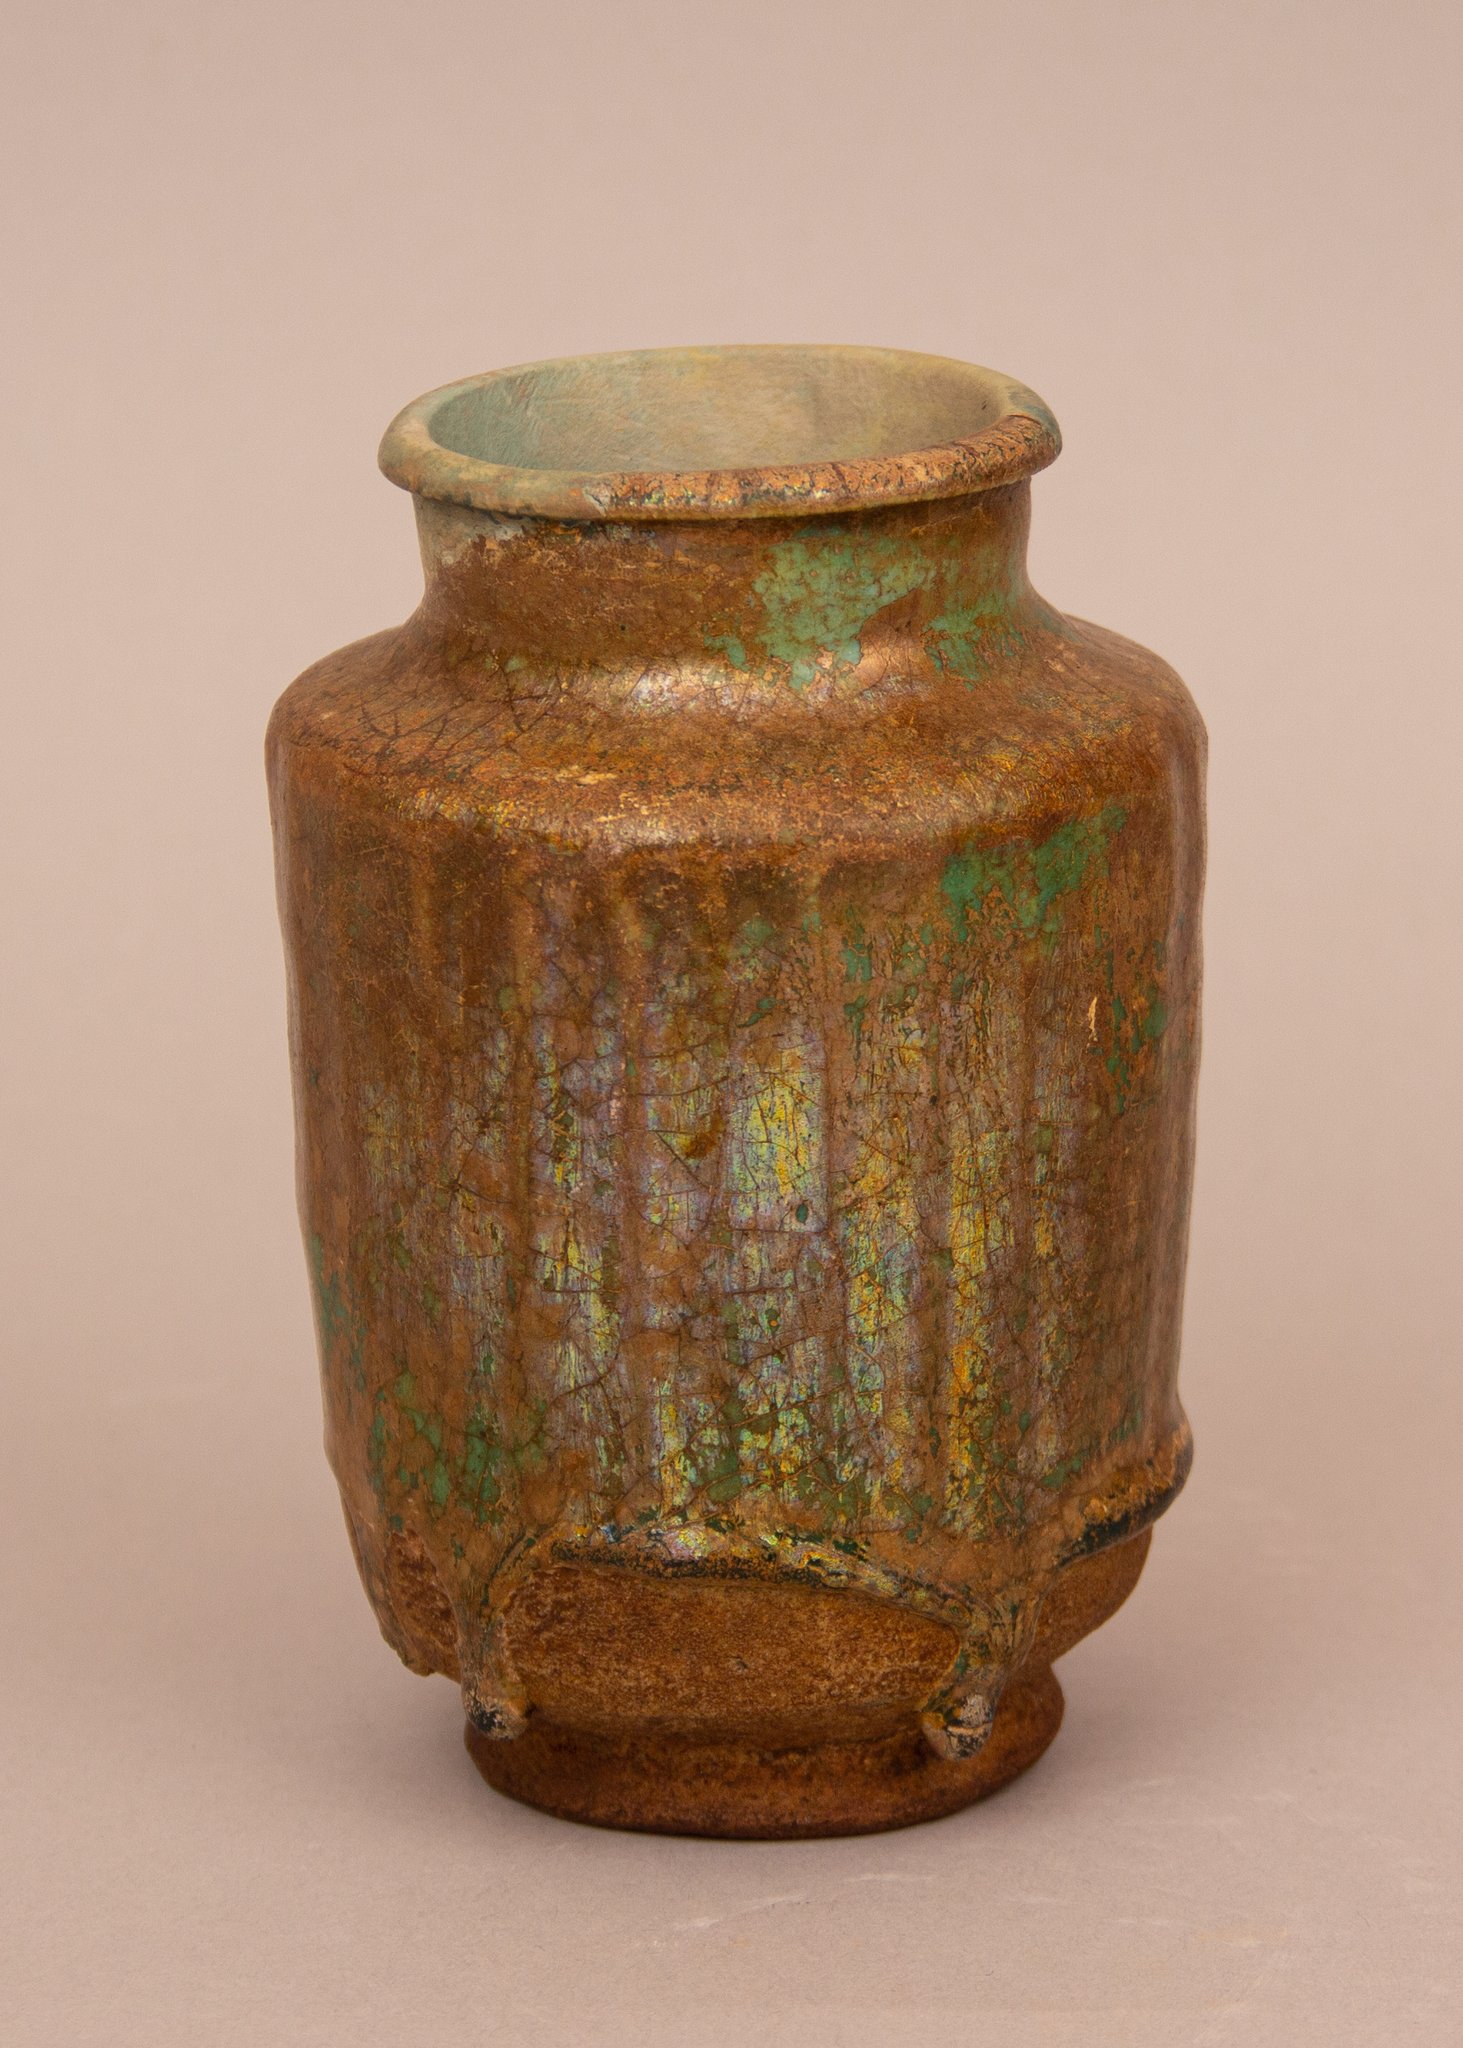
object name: jar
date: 1101-1200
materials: earthenware, glaze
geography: iran